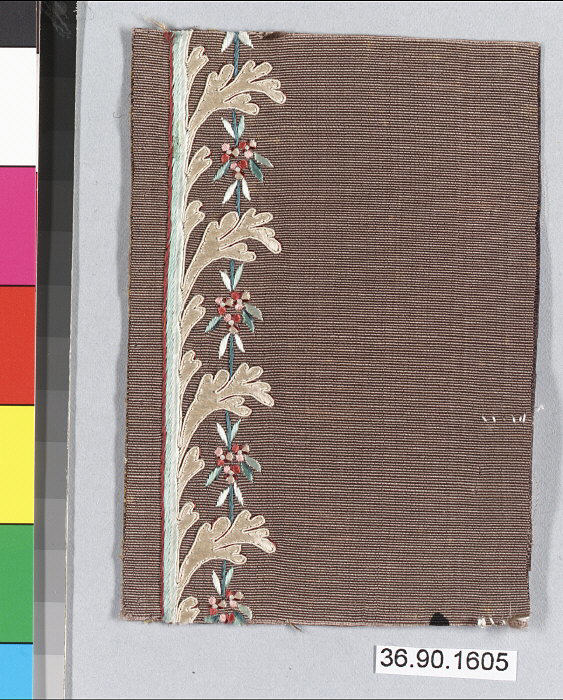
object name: sample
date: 1801-1833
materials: silk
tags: flowers,leaves